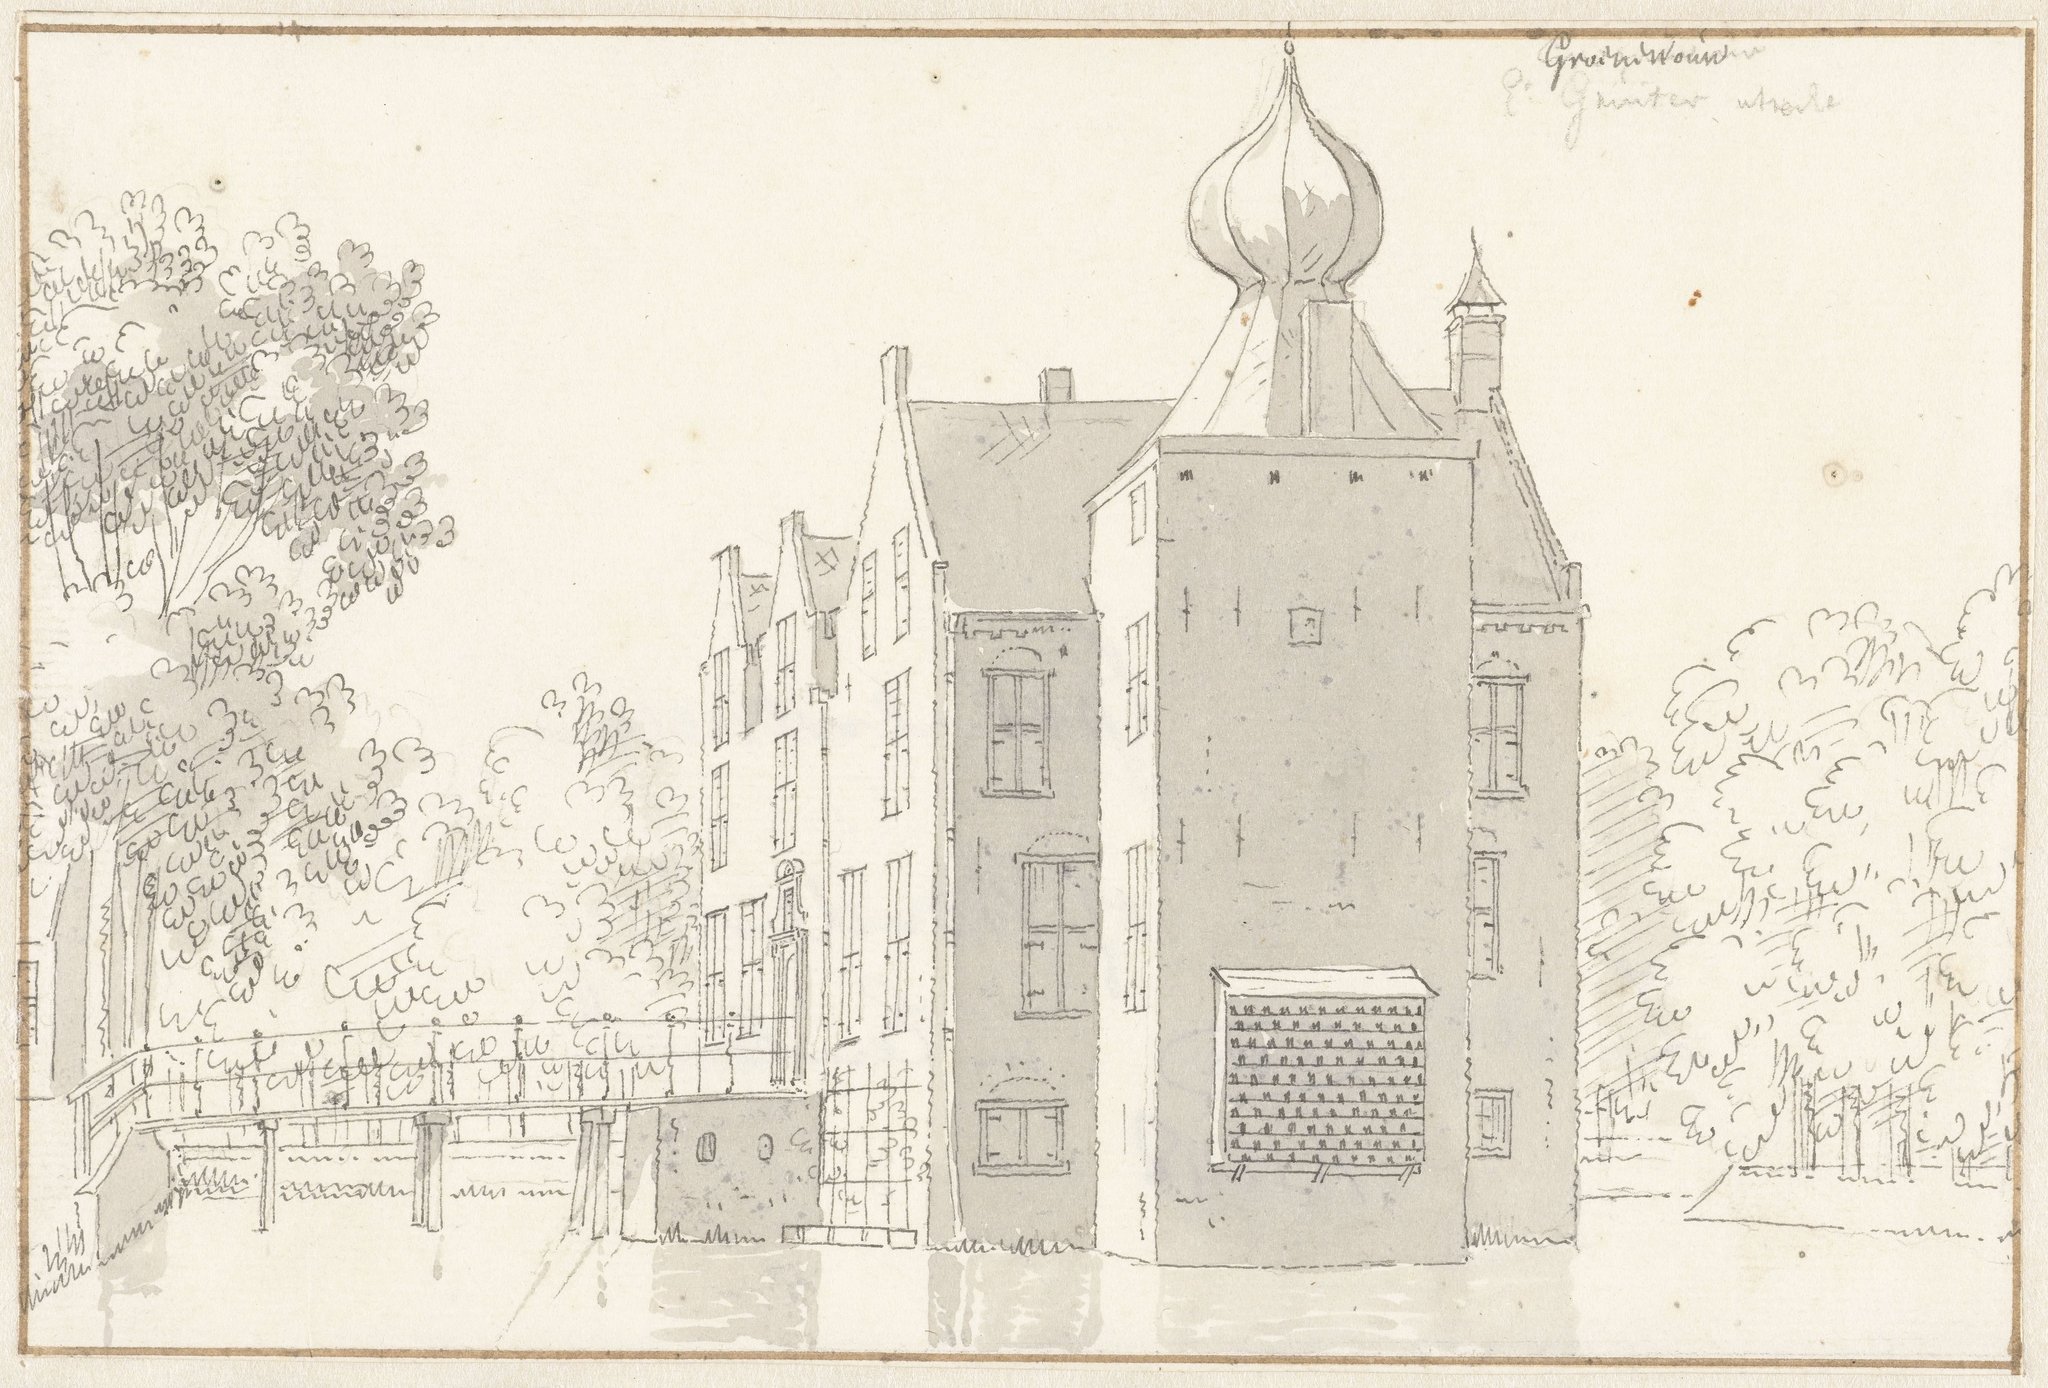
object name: drawing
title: Huis Groenewoude bij Amersfoort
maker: cornelis pronk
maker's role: draughtsman, painter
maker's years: 1691-1759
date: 1701-1759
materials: ink, paper, pencil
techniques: brush, pen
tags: city-view, and landscape with man-made constructions, castle